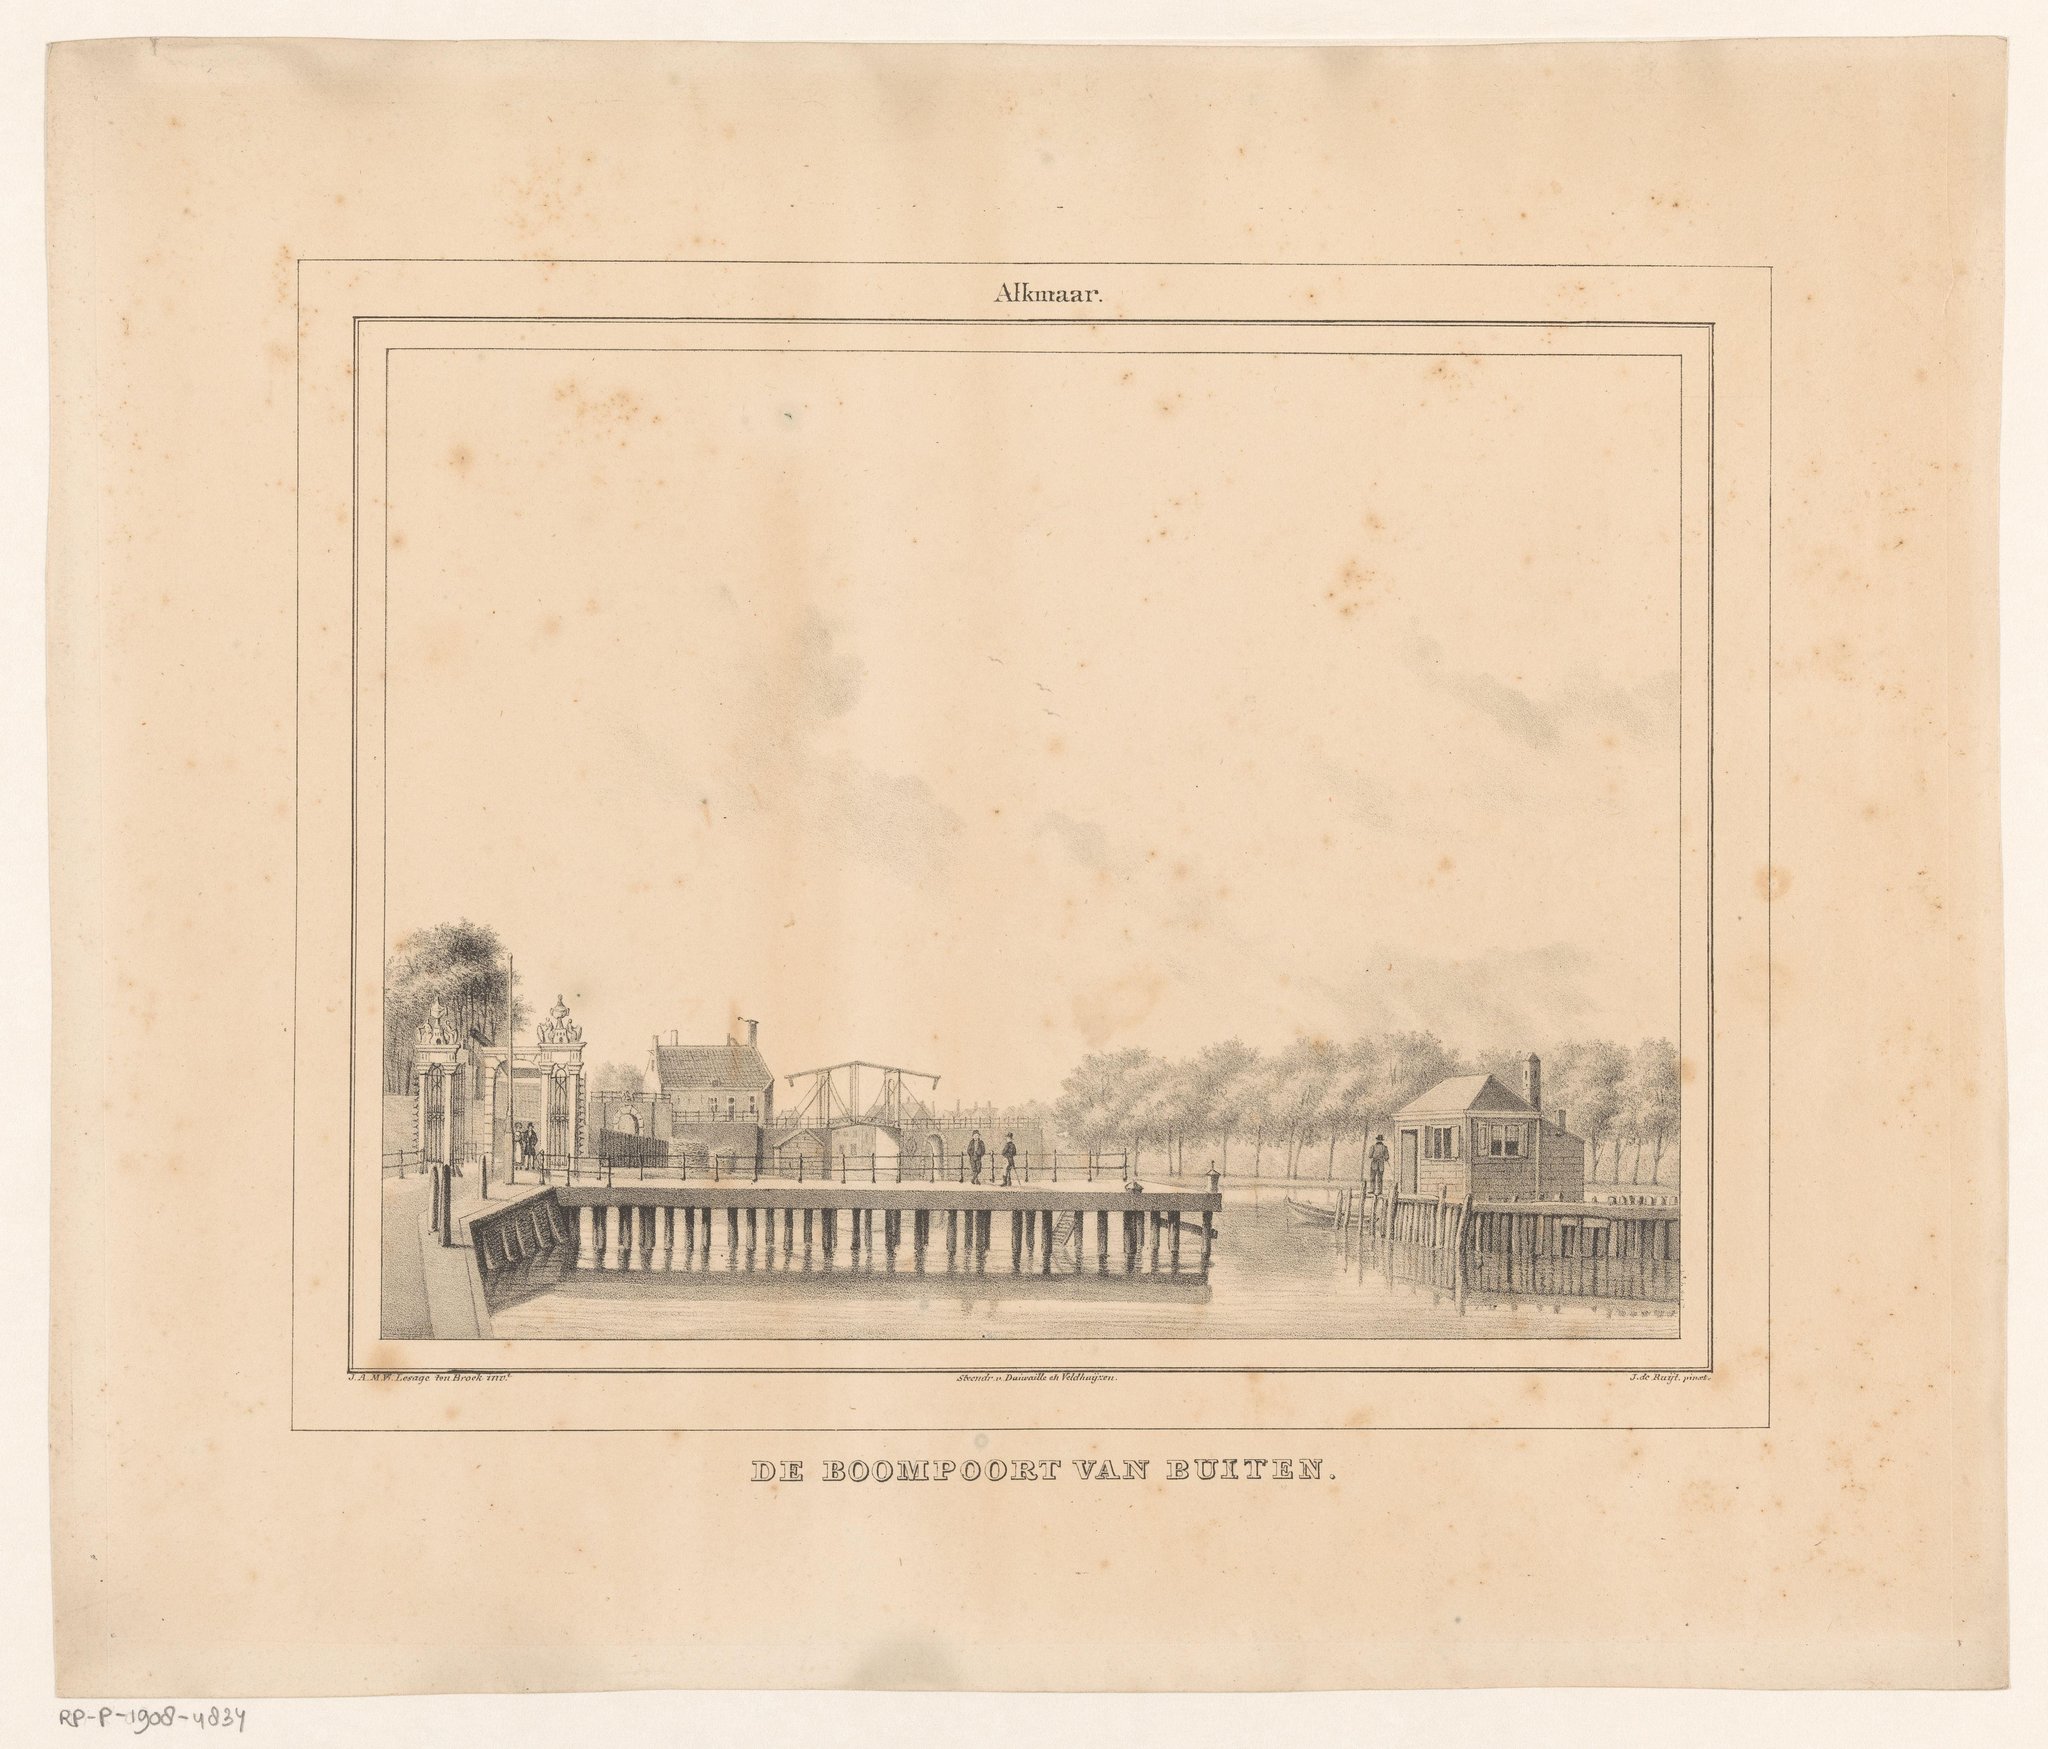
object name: print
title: Alkmaar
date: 1831-1835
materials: paper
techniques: lithograph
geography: amsterdam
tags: pier, quay, wharf, city-gate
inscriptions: collector's mark: Lugt 2228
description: De poort ligt links van de Hoge Brug. Over het water loopt een steiger, rechts het Sasserhuisje.